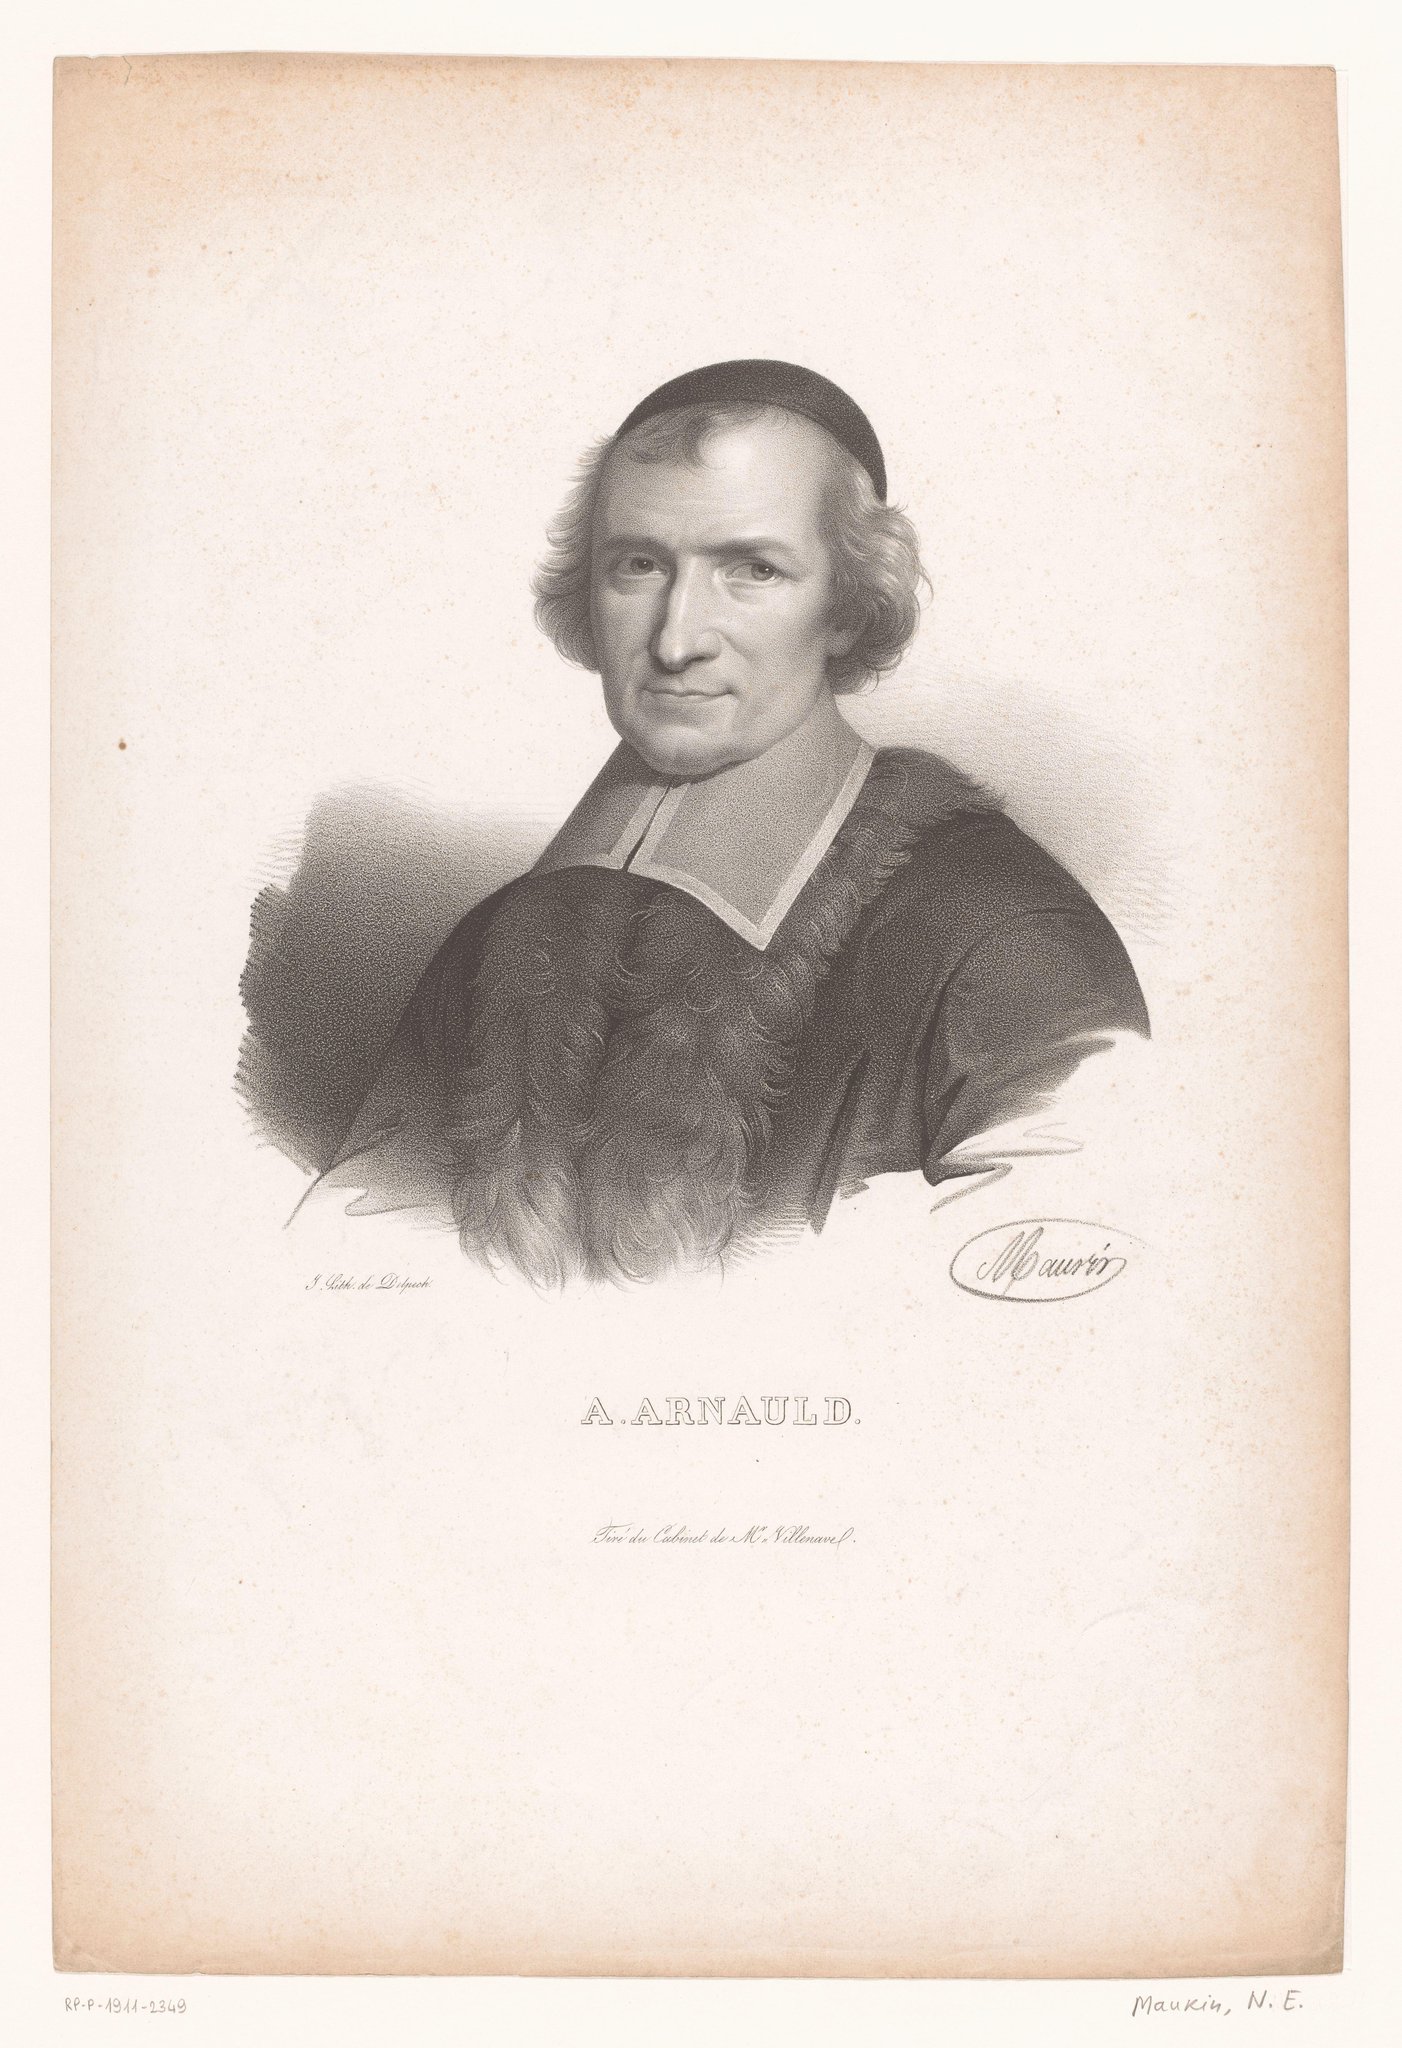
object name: print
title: Portret van Antoine Arnauld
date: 1825-1842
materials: paper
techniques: lithograph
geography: paris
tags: paris, brussels, historical persons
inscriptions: collector's mark: Lugt 2228